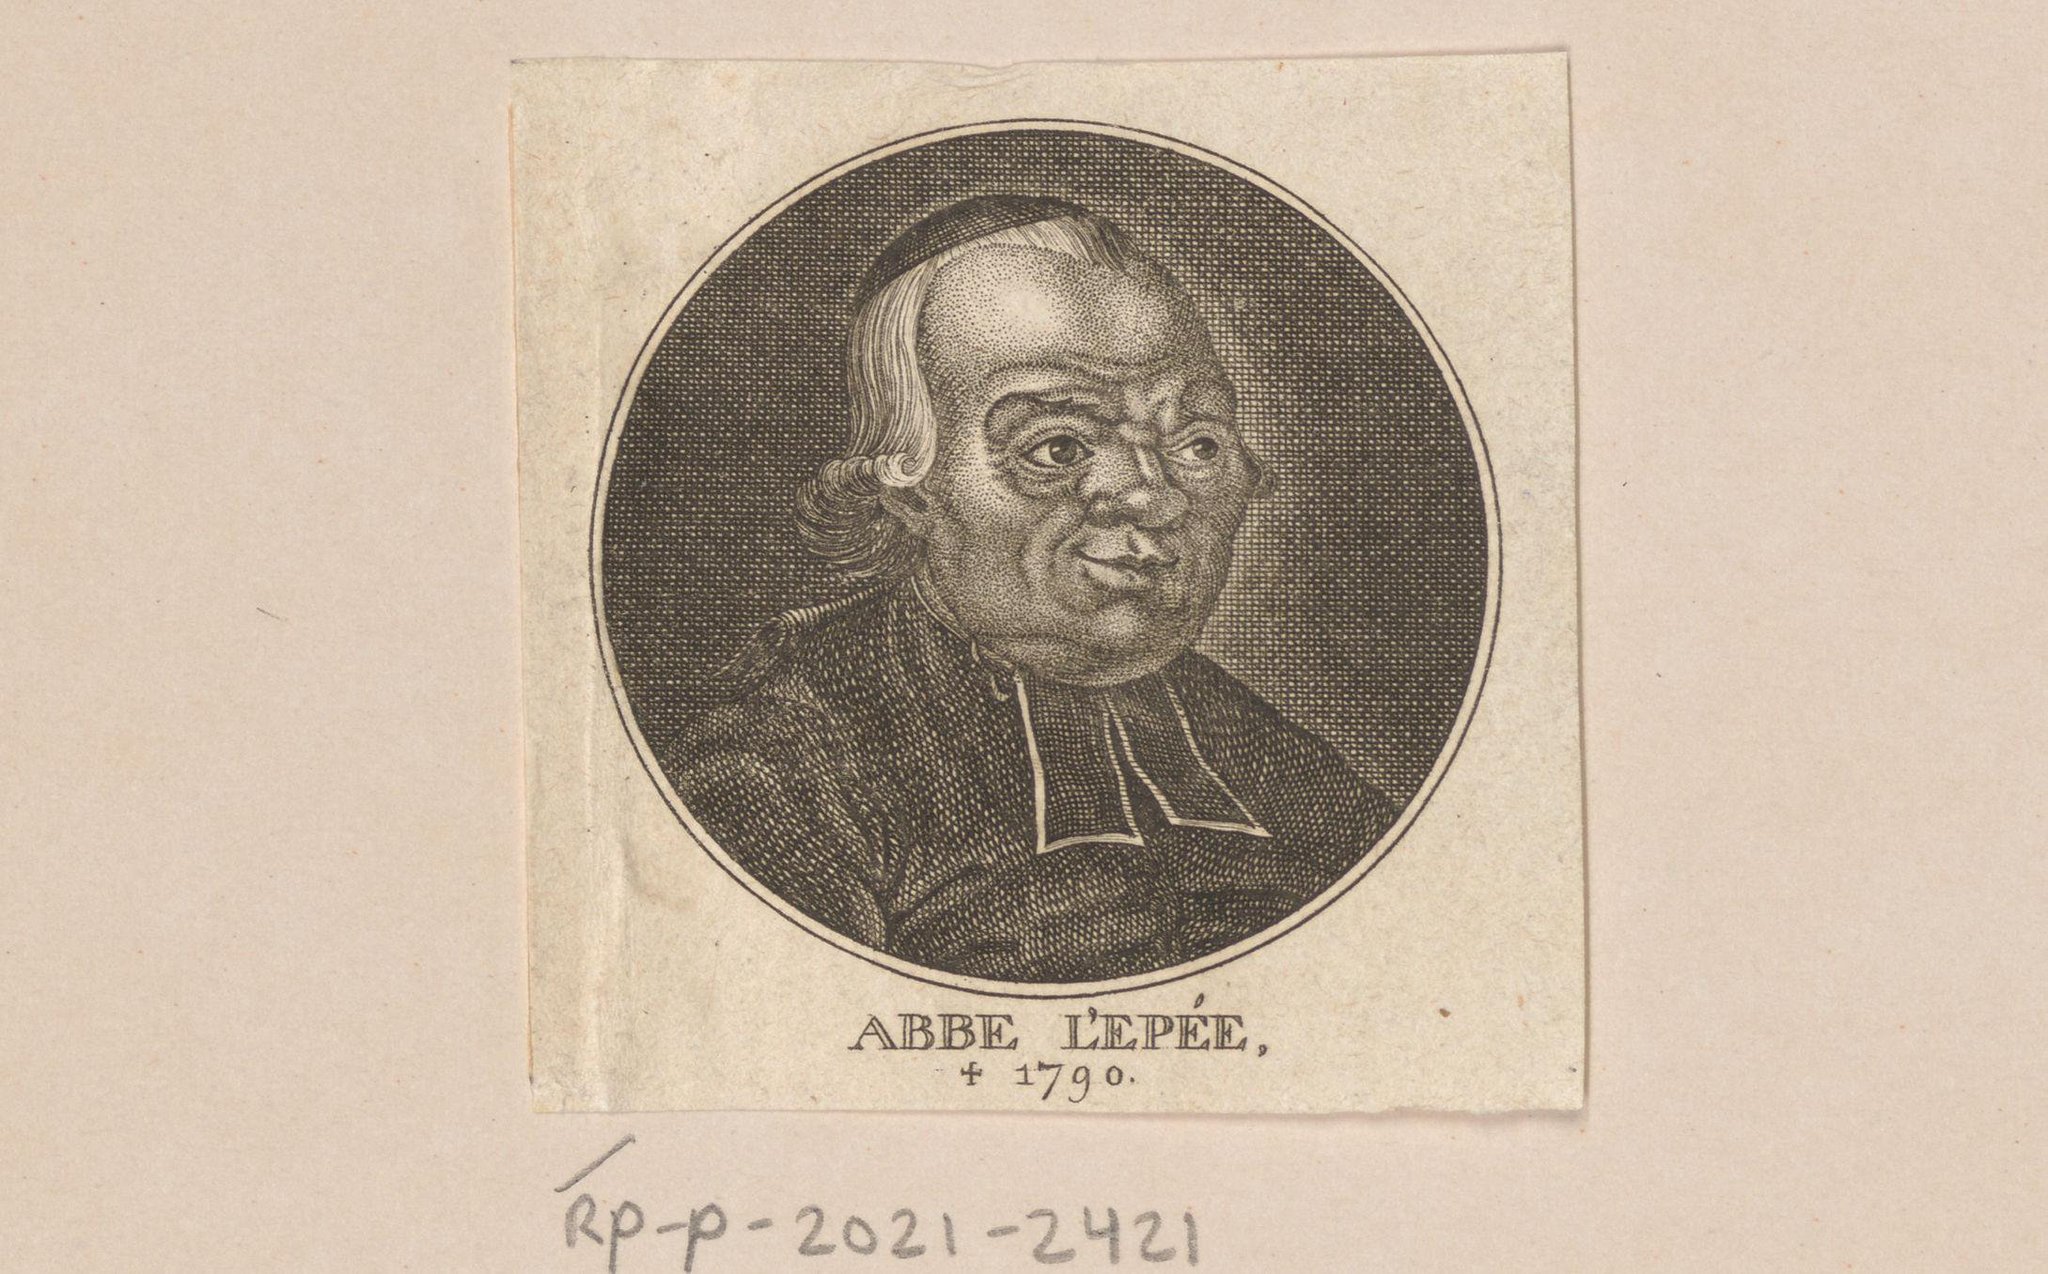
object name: print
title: Portret van Charles-Michel de l'Épée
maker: Anonymous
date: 1790-1850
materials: paper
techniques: etching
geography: france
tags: paris, historical persons